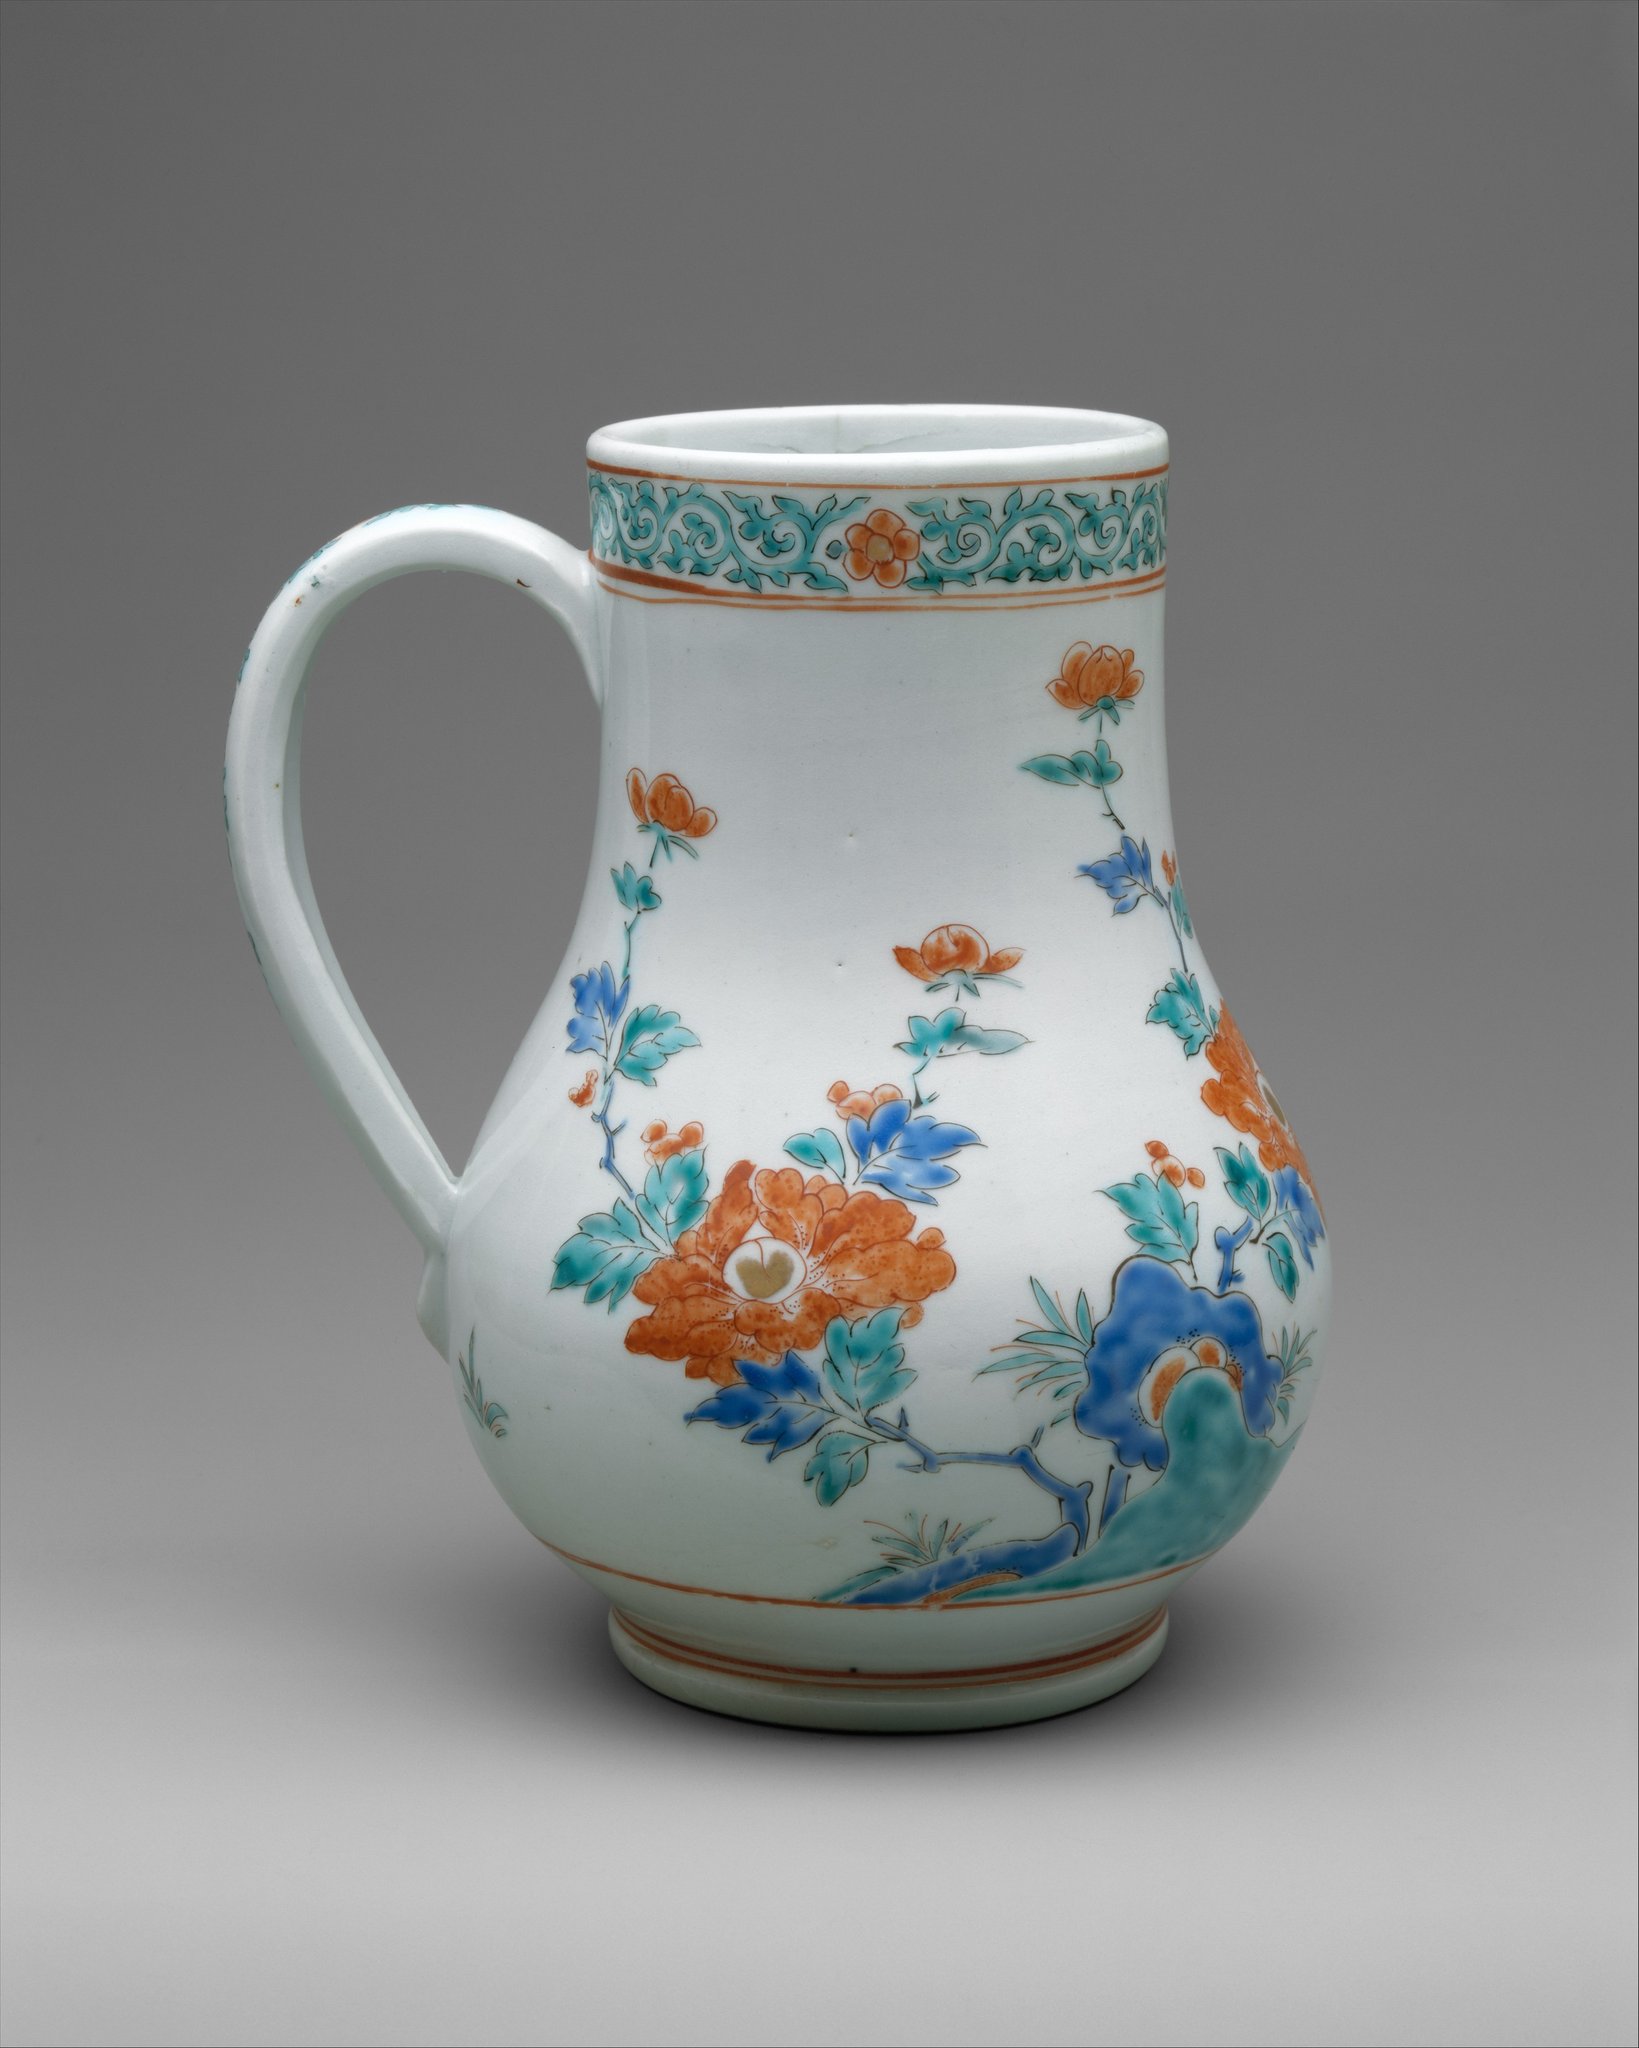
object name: ewer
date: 1701-1733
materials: hard paste porcelain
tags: flowers